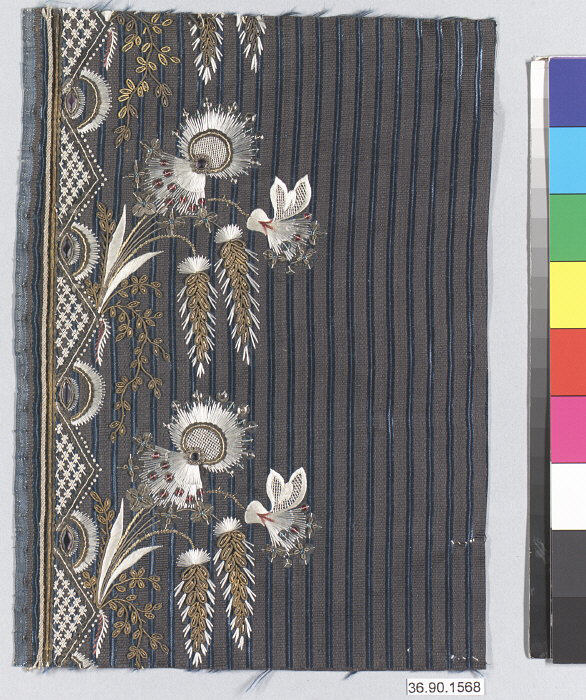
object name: sample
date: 1801-1833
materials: metal thread, silk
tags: flowers